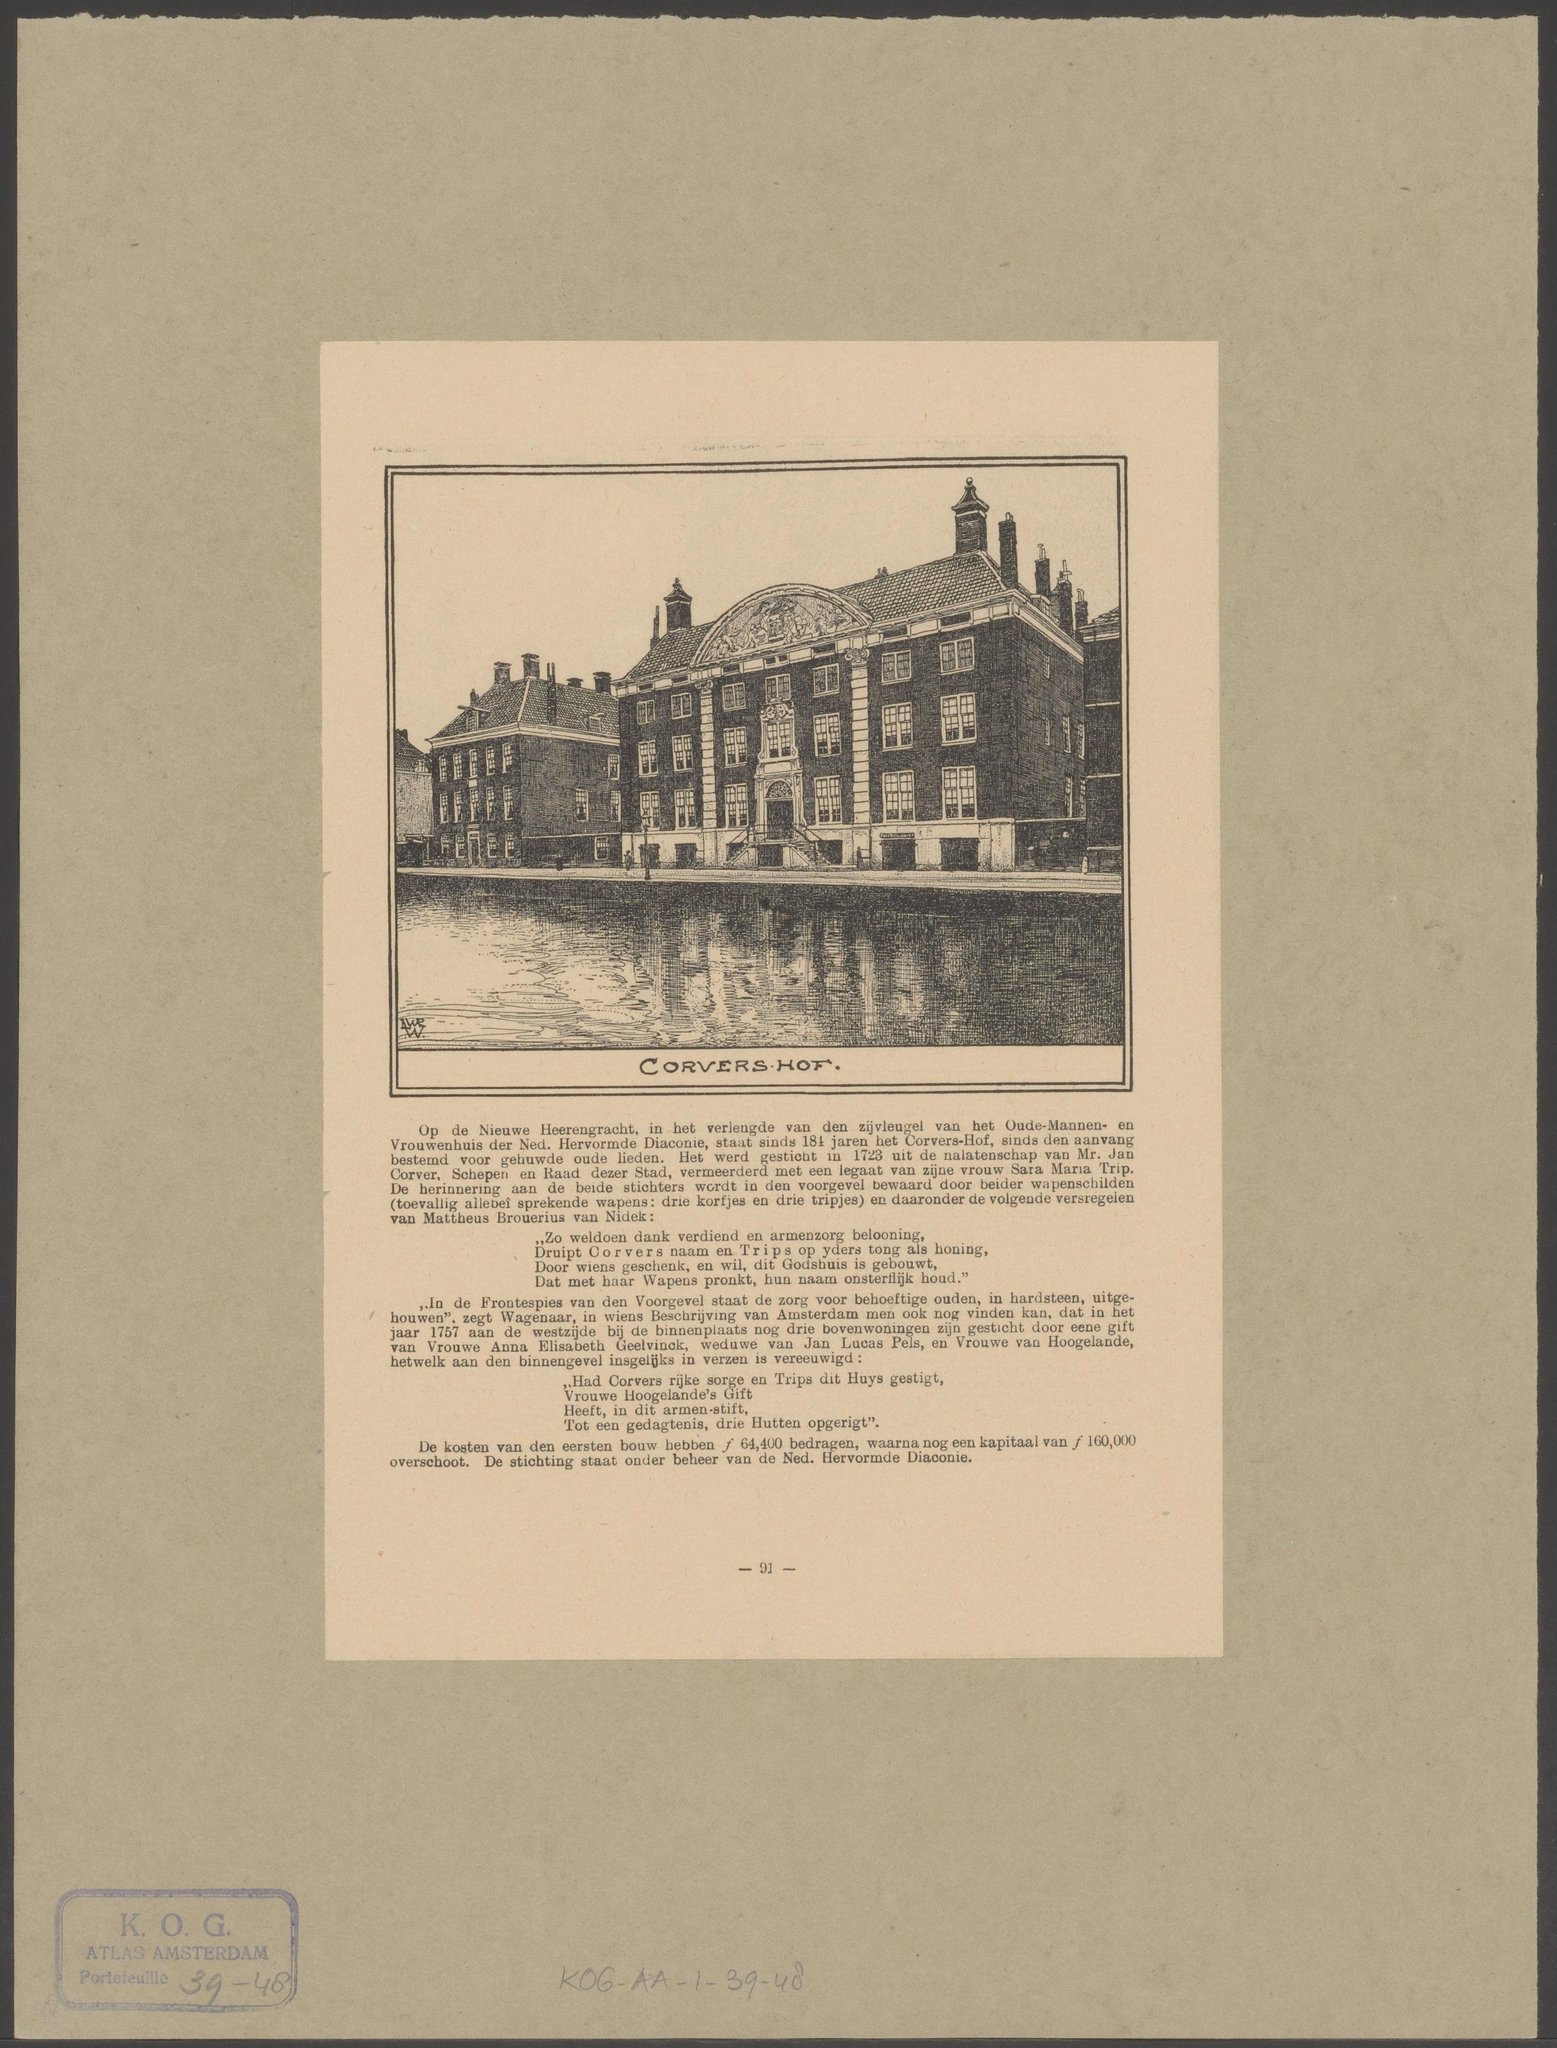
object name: book illustration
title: Corvers Hof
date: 1907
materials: paper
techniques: letterpress printing, line block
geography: amsterdam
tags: alms-house (dutch: 'hofje'), canals, waters (in city) (+ city(-scape) with figures, staffage)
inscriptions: collector's mark: Lugt 1641b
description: Onderwerpsrubriek binnen de Atlas Amsterdam: Armwezen en liefdadige instellingen: III. Verschillende gestichten en instellingen / Hofjes: Corvershof der N. Hervormde Gemeente.